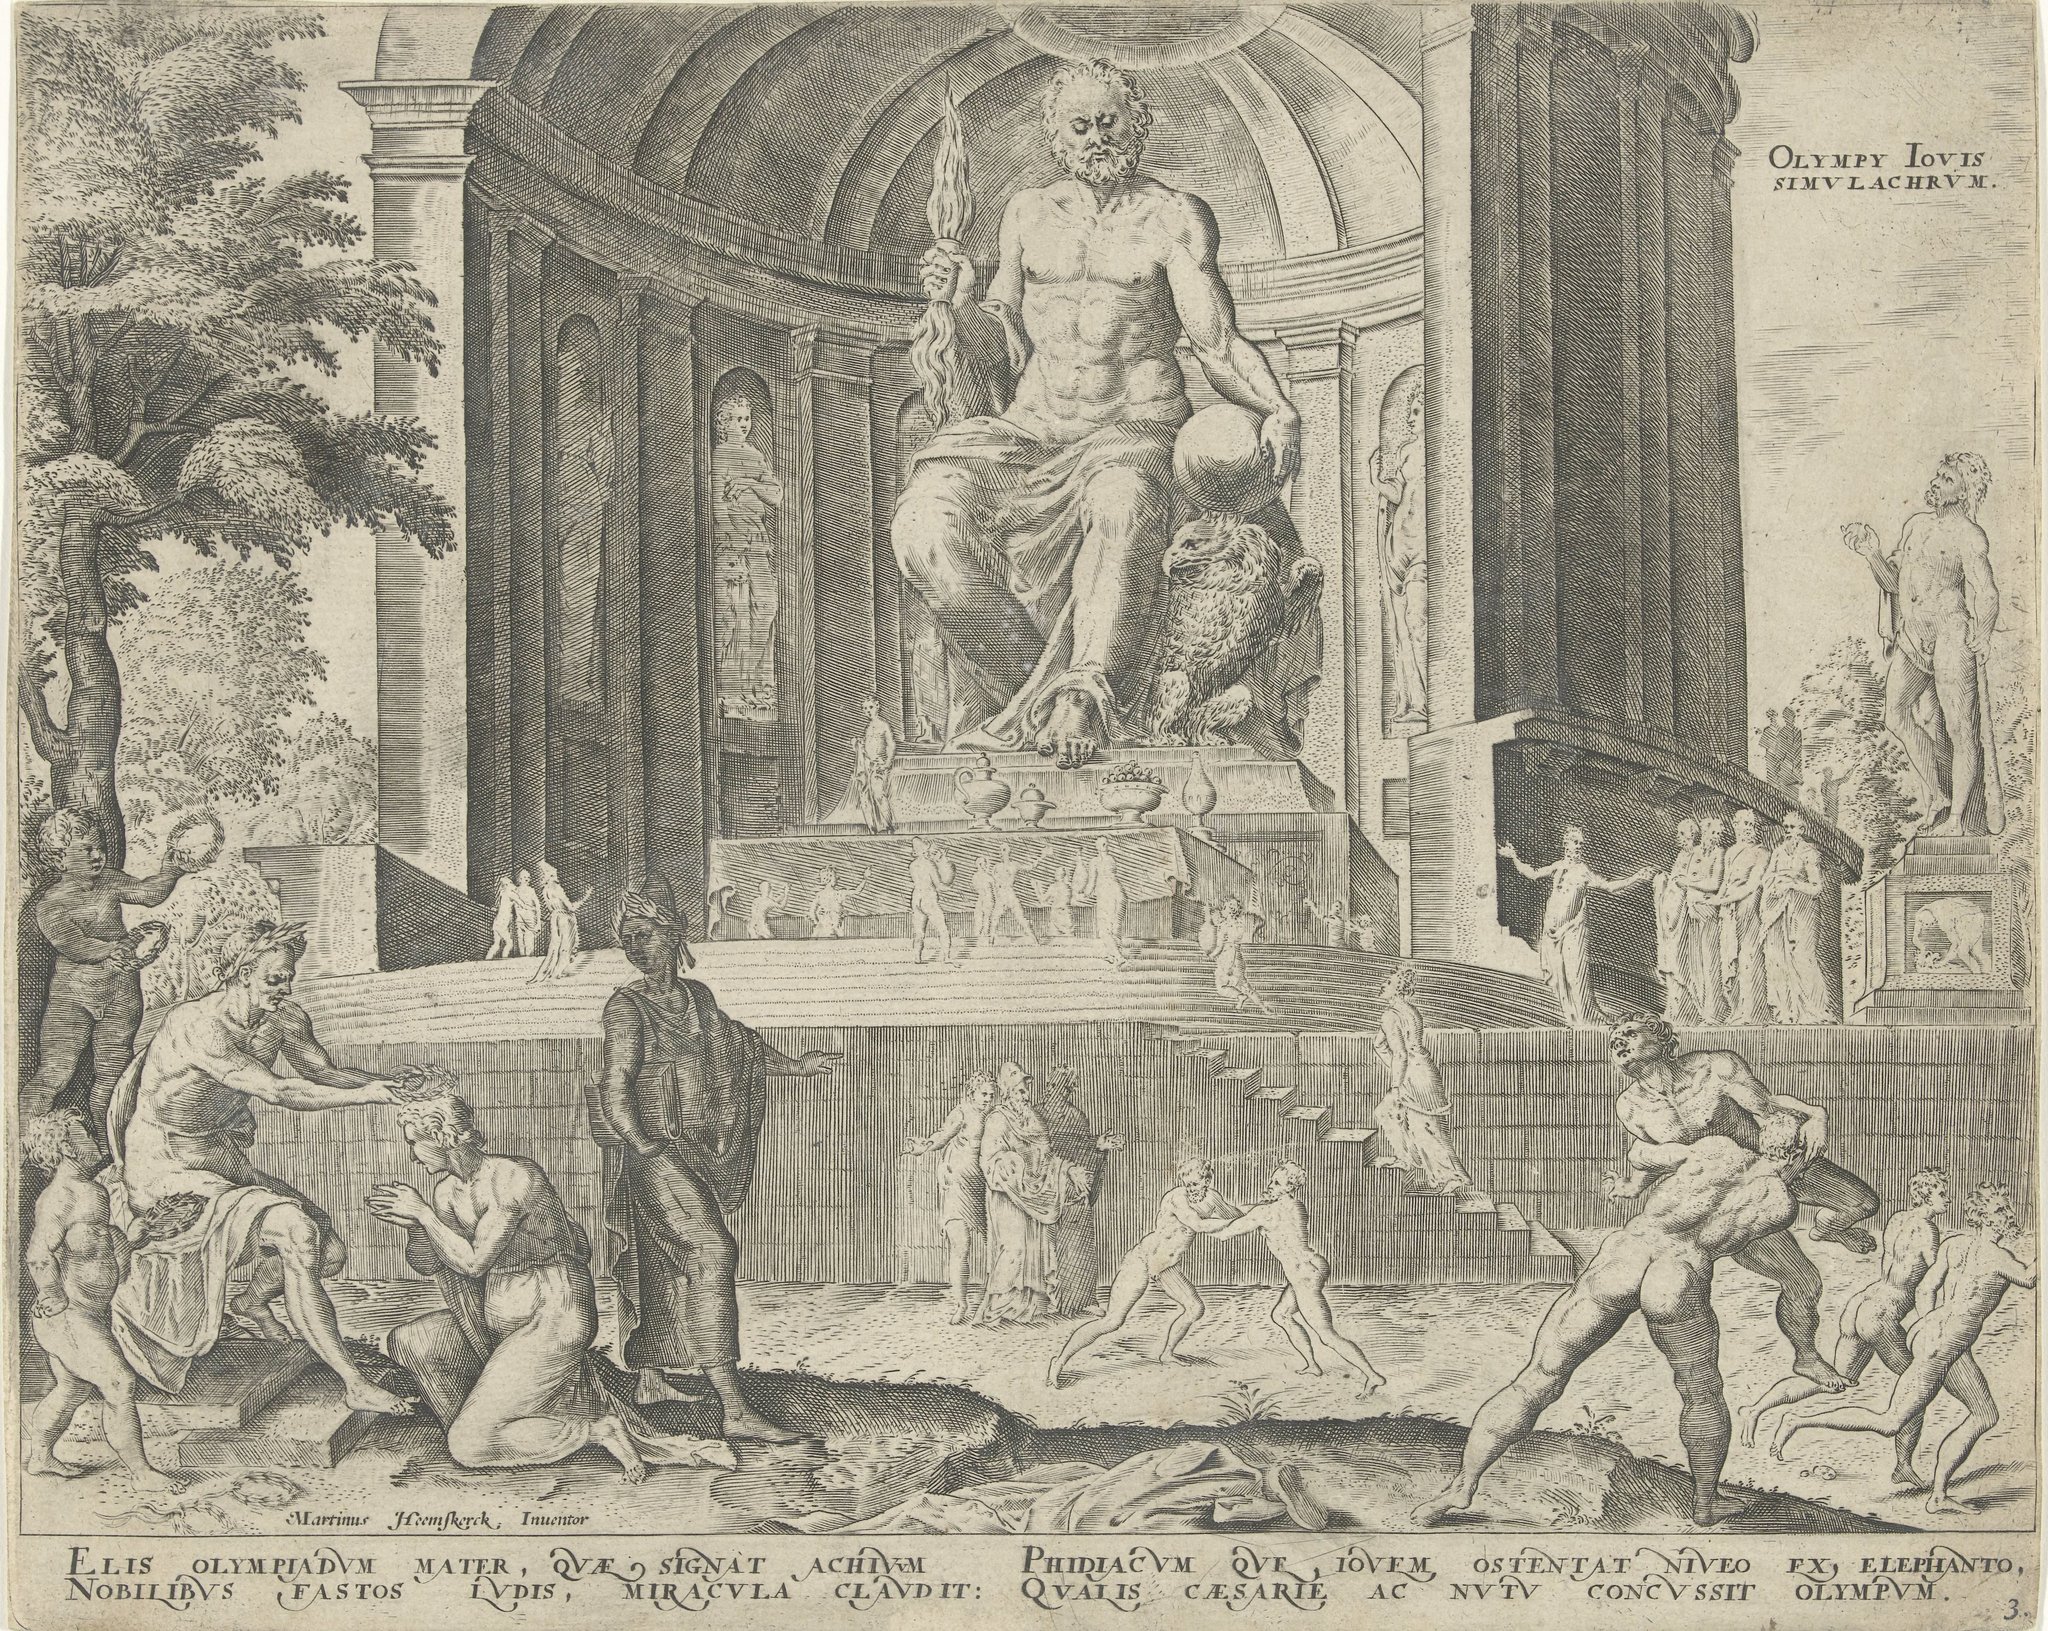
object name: print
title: Olympy Iovis simvlacrvm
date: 1572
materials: paper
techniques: engraving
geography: antwerp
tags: (story of) hercules (heracles), wrestling (sport), olympic games, in honour of zeus, statue of zeus by phidias (wonder of the world)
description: Het beeld van Zeus bevond zich binnen in de Dorische tempel van Olympia, op de Griekse Peloponnesus. Het werd omstreeks 433 v. Chr. gemaakt door de Atheense beeldhouwer Phidias. Rechts van de tempel een beeld van Hercules. Op de trappen voor de tempel mensen die het beeld van Zeus aanbidden. Op de voorgrond rechts Olympische worstelaars en renners, links wordt een van de winnaars gelauwerd. De prent heeft een Latijns onderschrift en maakt deel uit van een serie over de acht wereldwonderen.